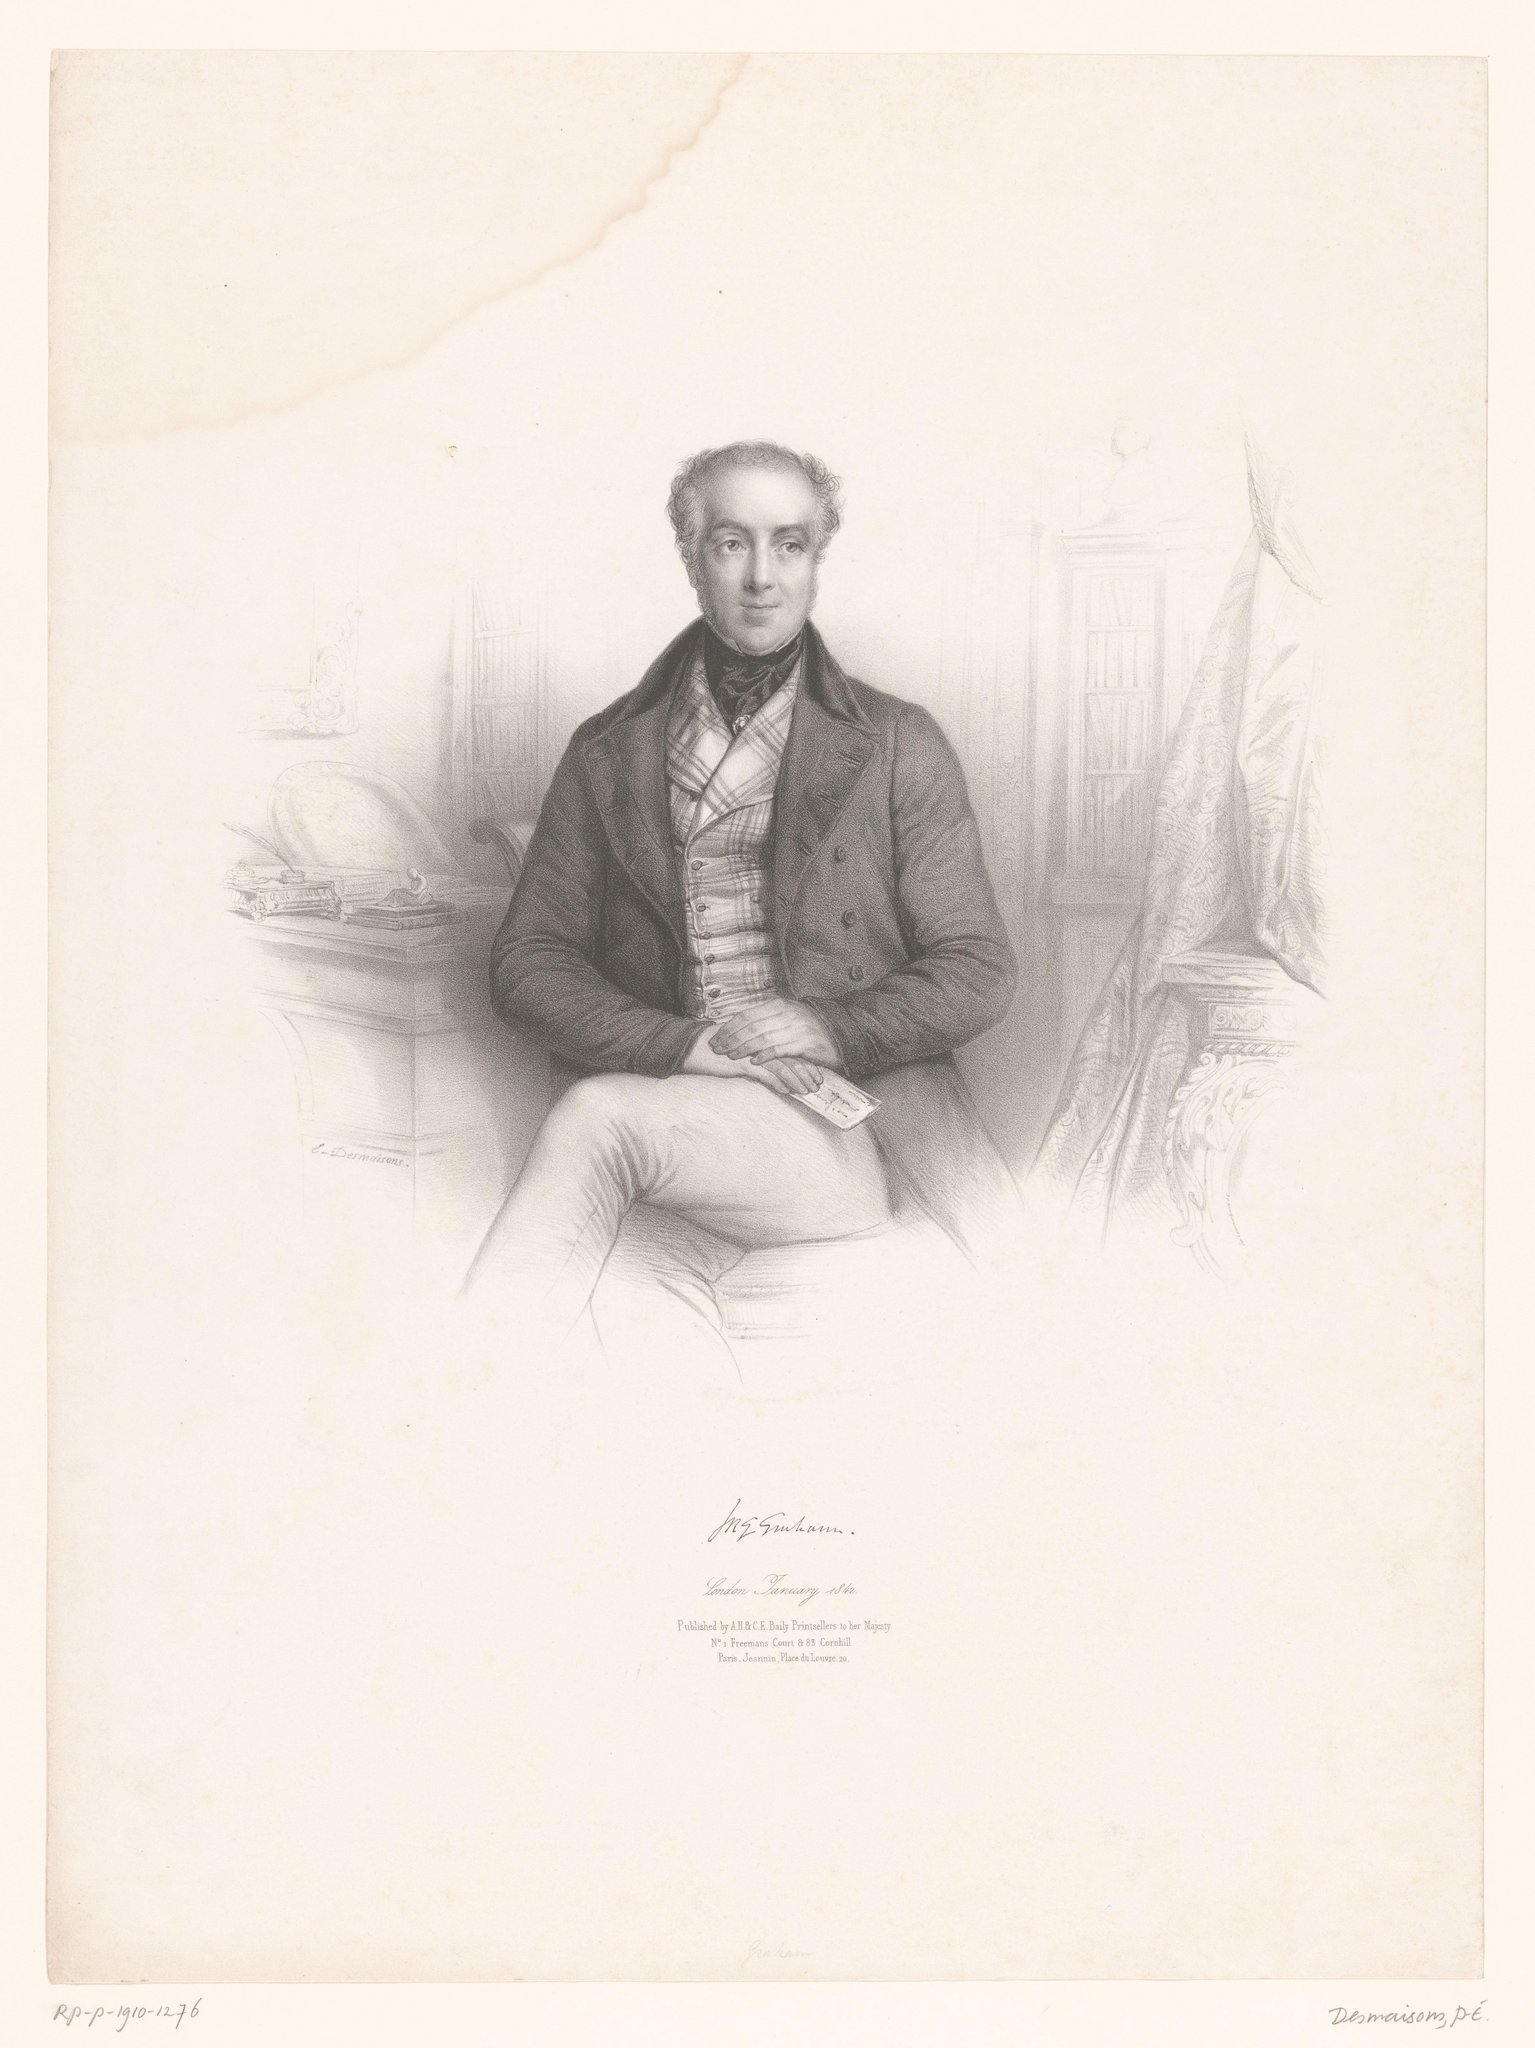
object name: print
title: J.R.G. Graham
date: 1842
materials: paper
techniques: lithograph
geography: london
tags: politician, historical persons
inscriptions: collector's mark: Lugt 2228a